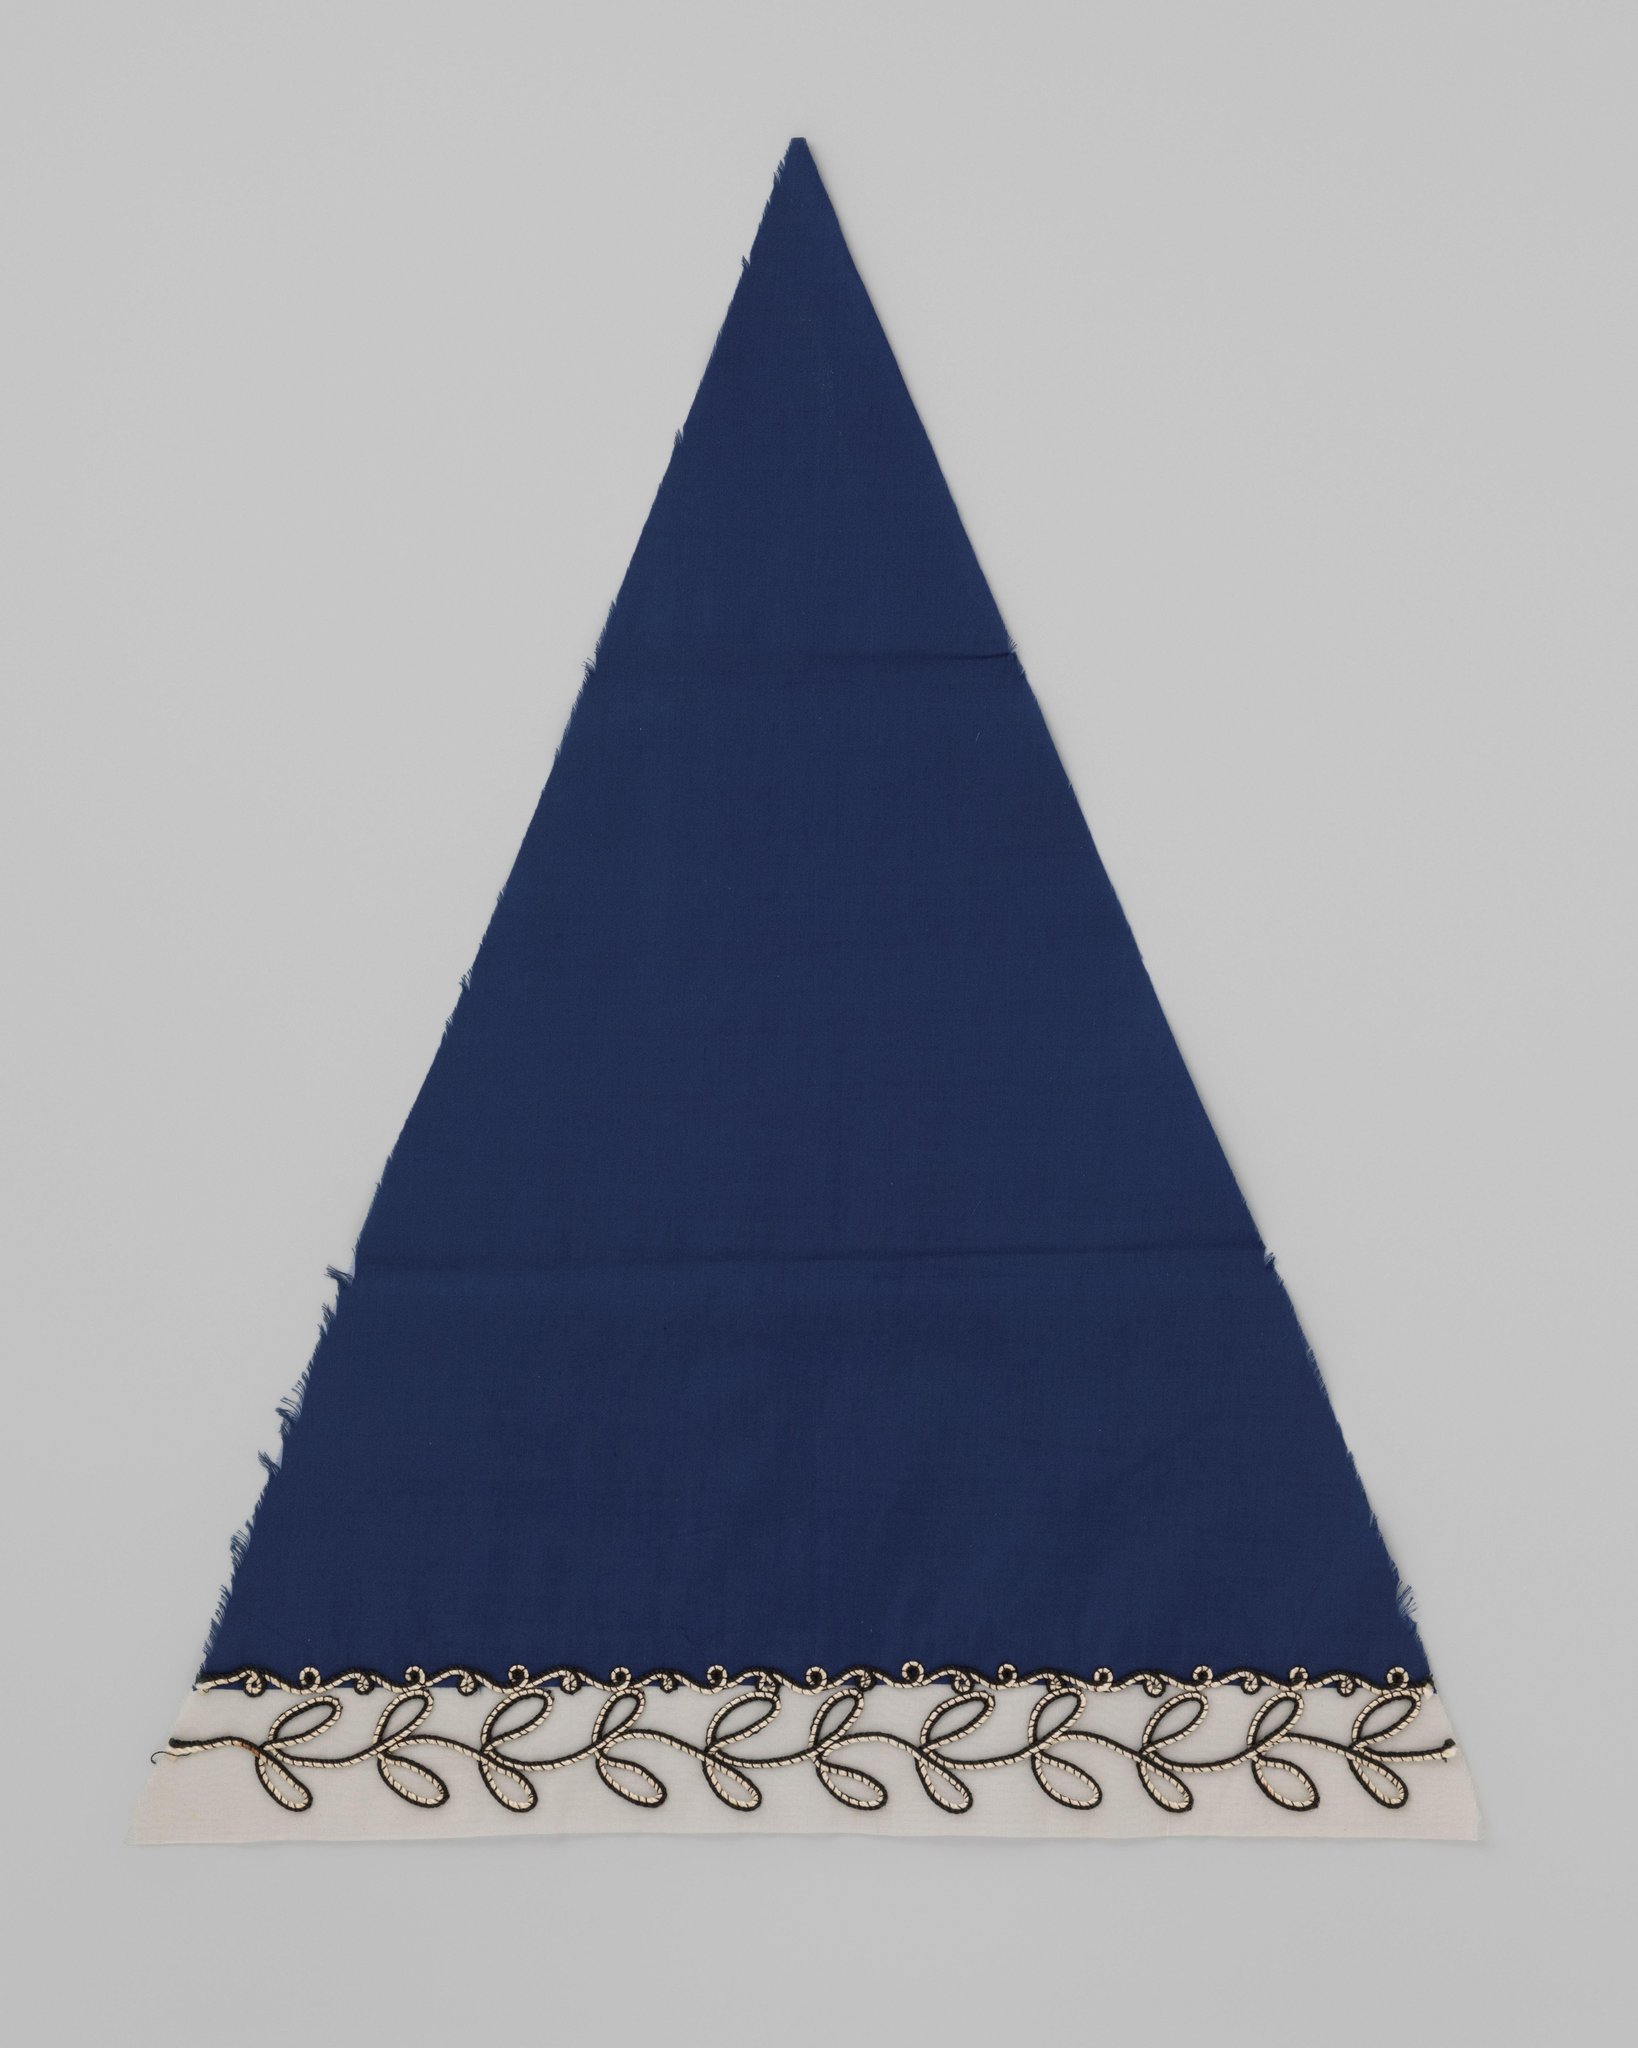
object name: parasoldek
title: Sector van een parasoldek van donkerblauw katoen, met een met woldraad geborduurde rand van batist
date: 1885-1900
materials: cotton, wool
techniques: embroidered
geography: nijmegen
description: Sector van een parasoldek van donkerblauw katoen, met een met woldraad geborduurde rand van batist.